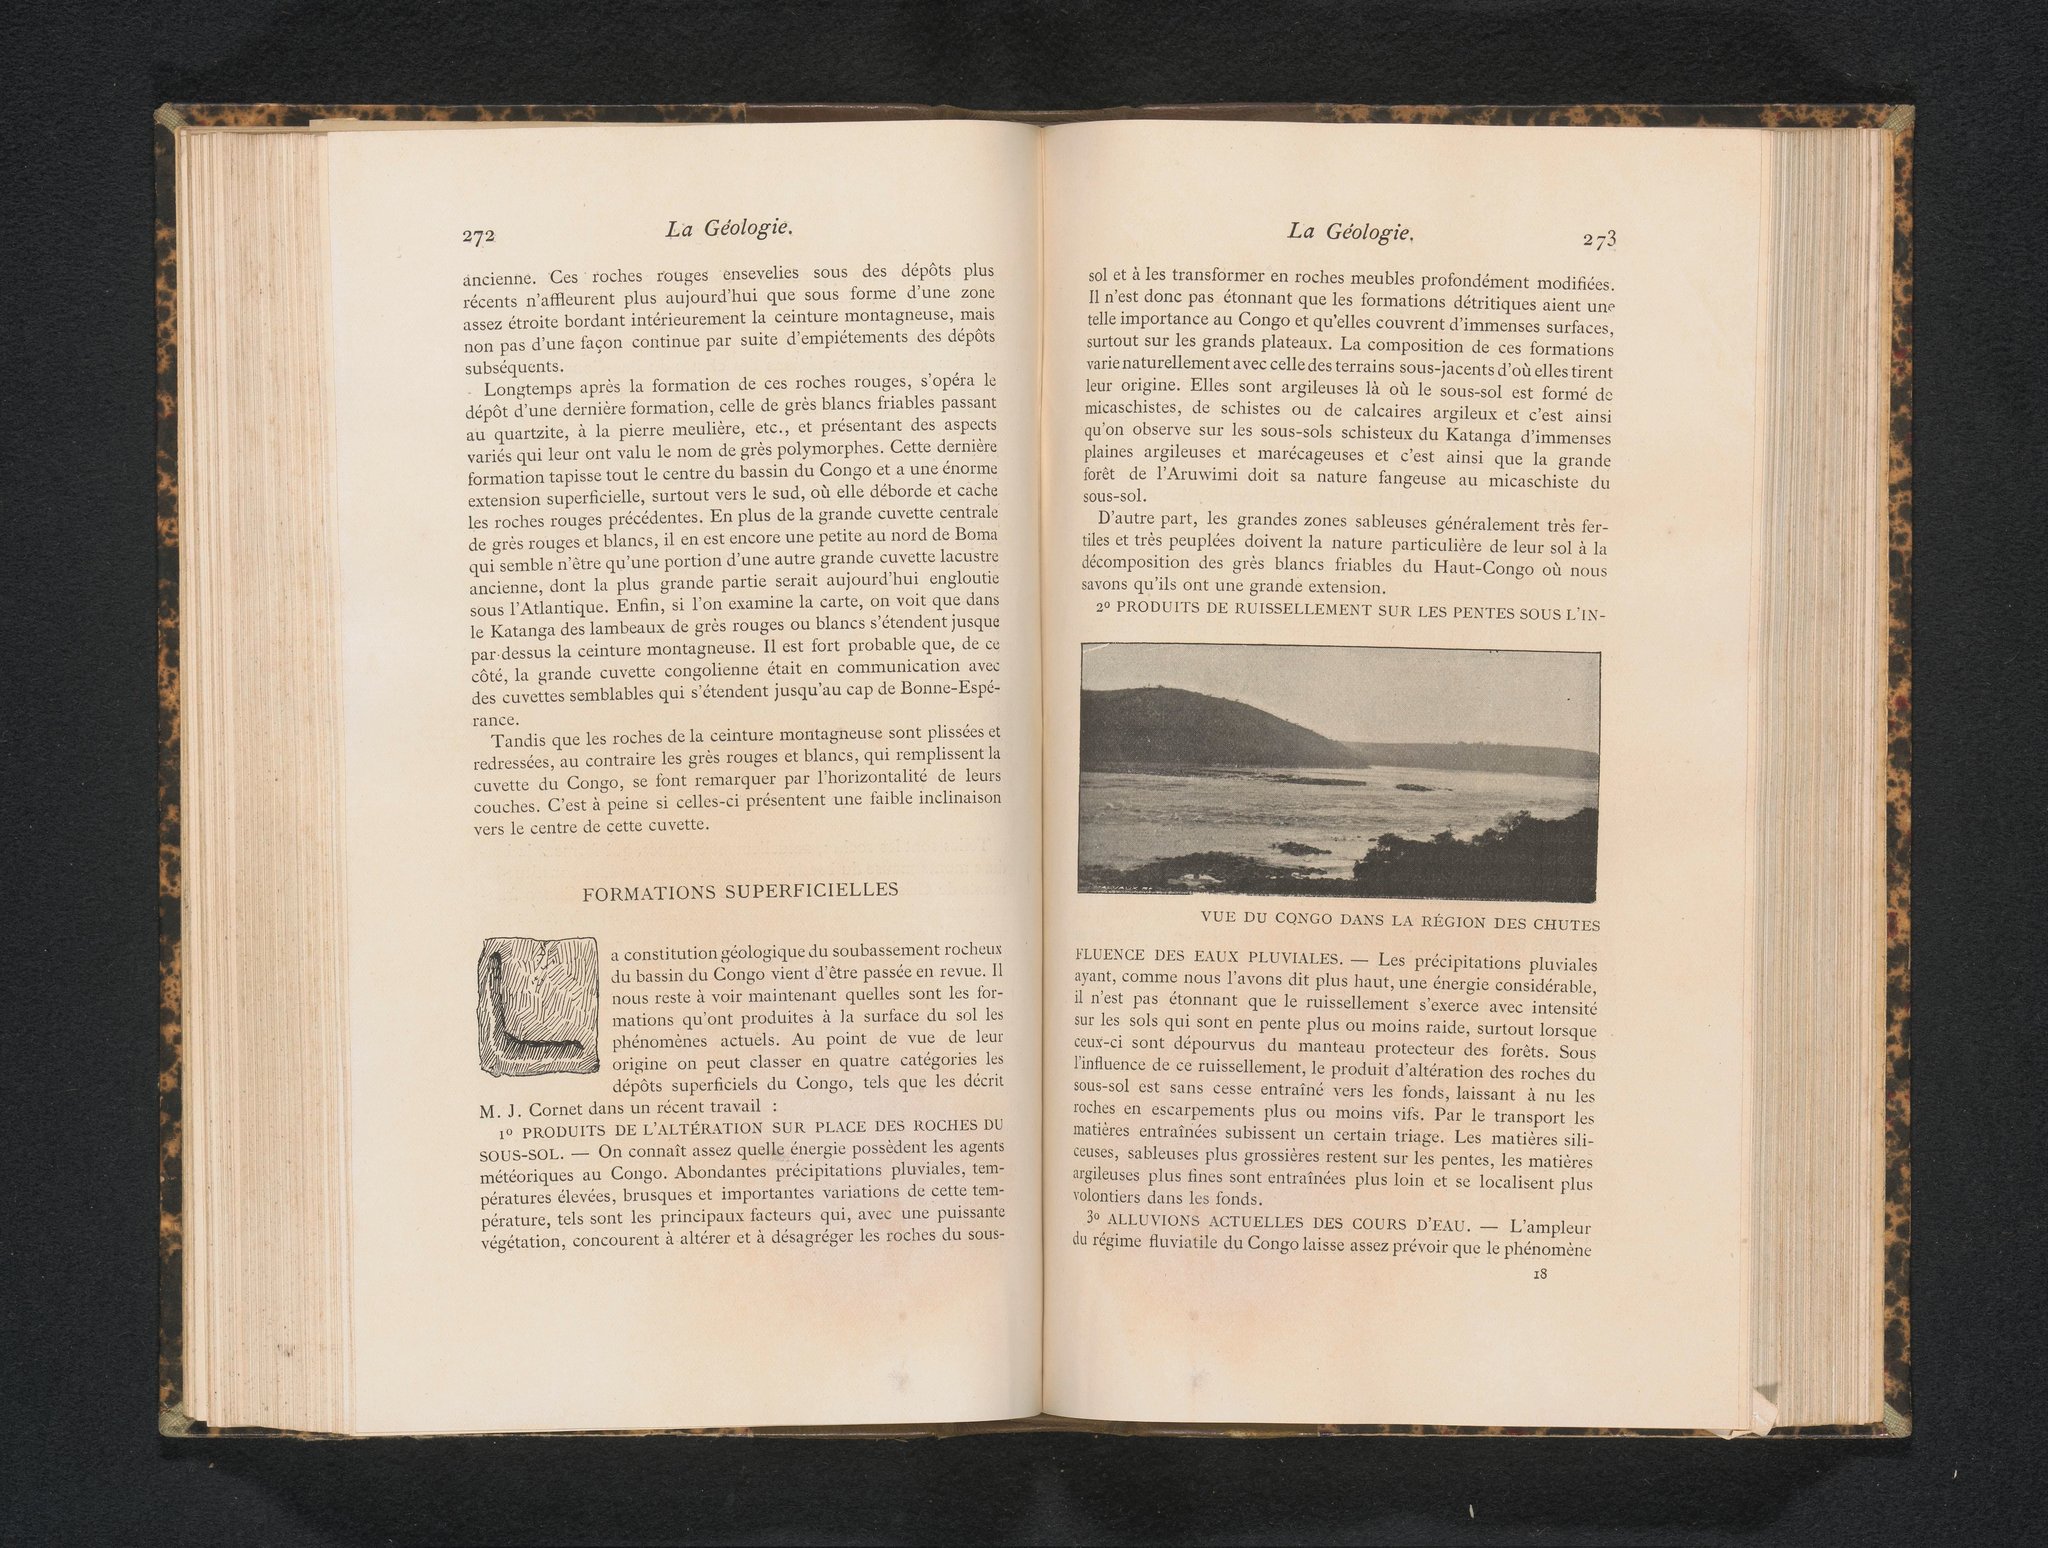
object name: page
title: Vue du Congo dans la région des chutes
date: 1887-1892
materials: paper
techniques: autotype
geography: congo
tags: rapids, river